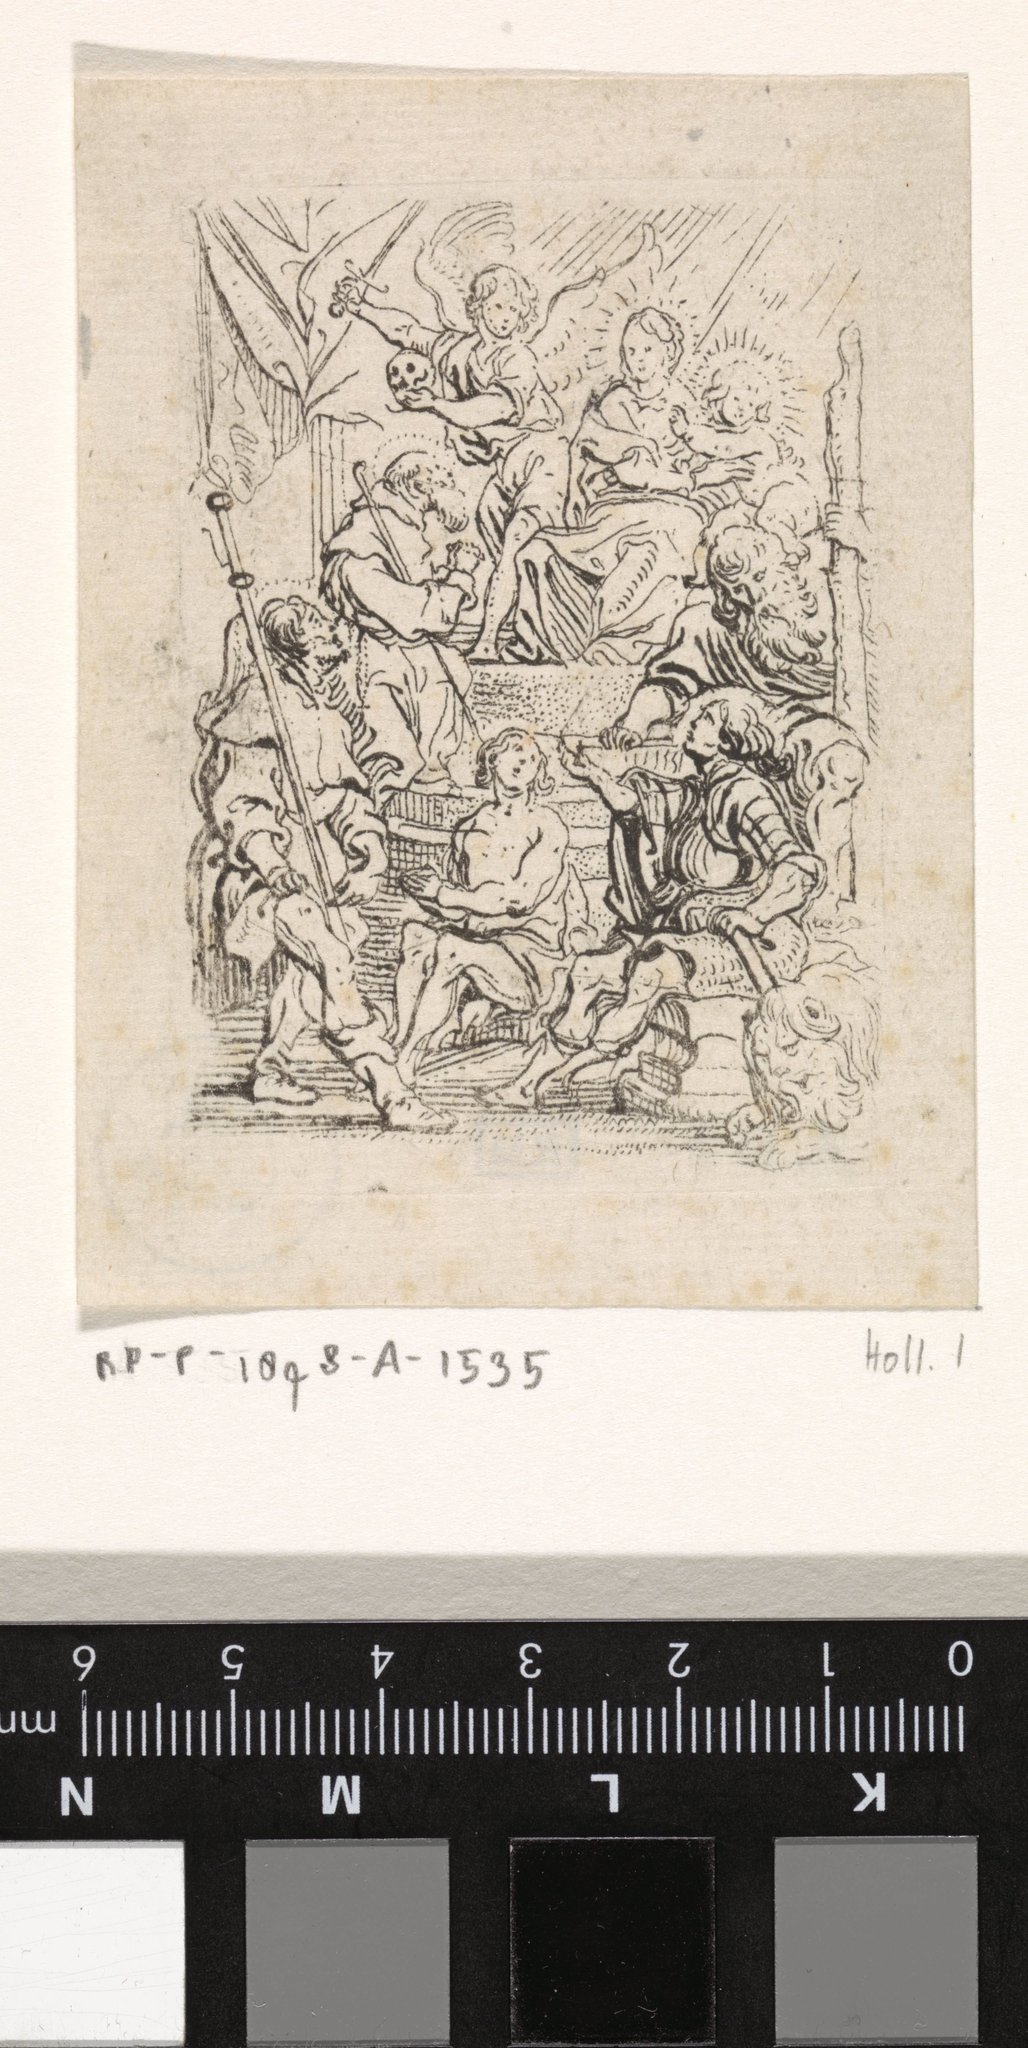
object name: print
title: Tronende Maria en het kind omringd door heiligen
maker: antoine sallaert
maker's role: draughtsman, print maker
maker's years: 1580-1650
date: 1590-1650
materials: paper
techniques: etching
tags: the virgin mary, the giant and martyr christophorus; possible attributes: palm-tree (with bunches of dates, or withered), infant christ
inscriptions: collector's mark: Lugt 2227, collector's mark: Lugt 514